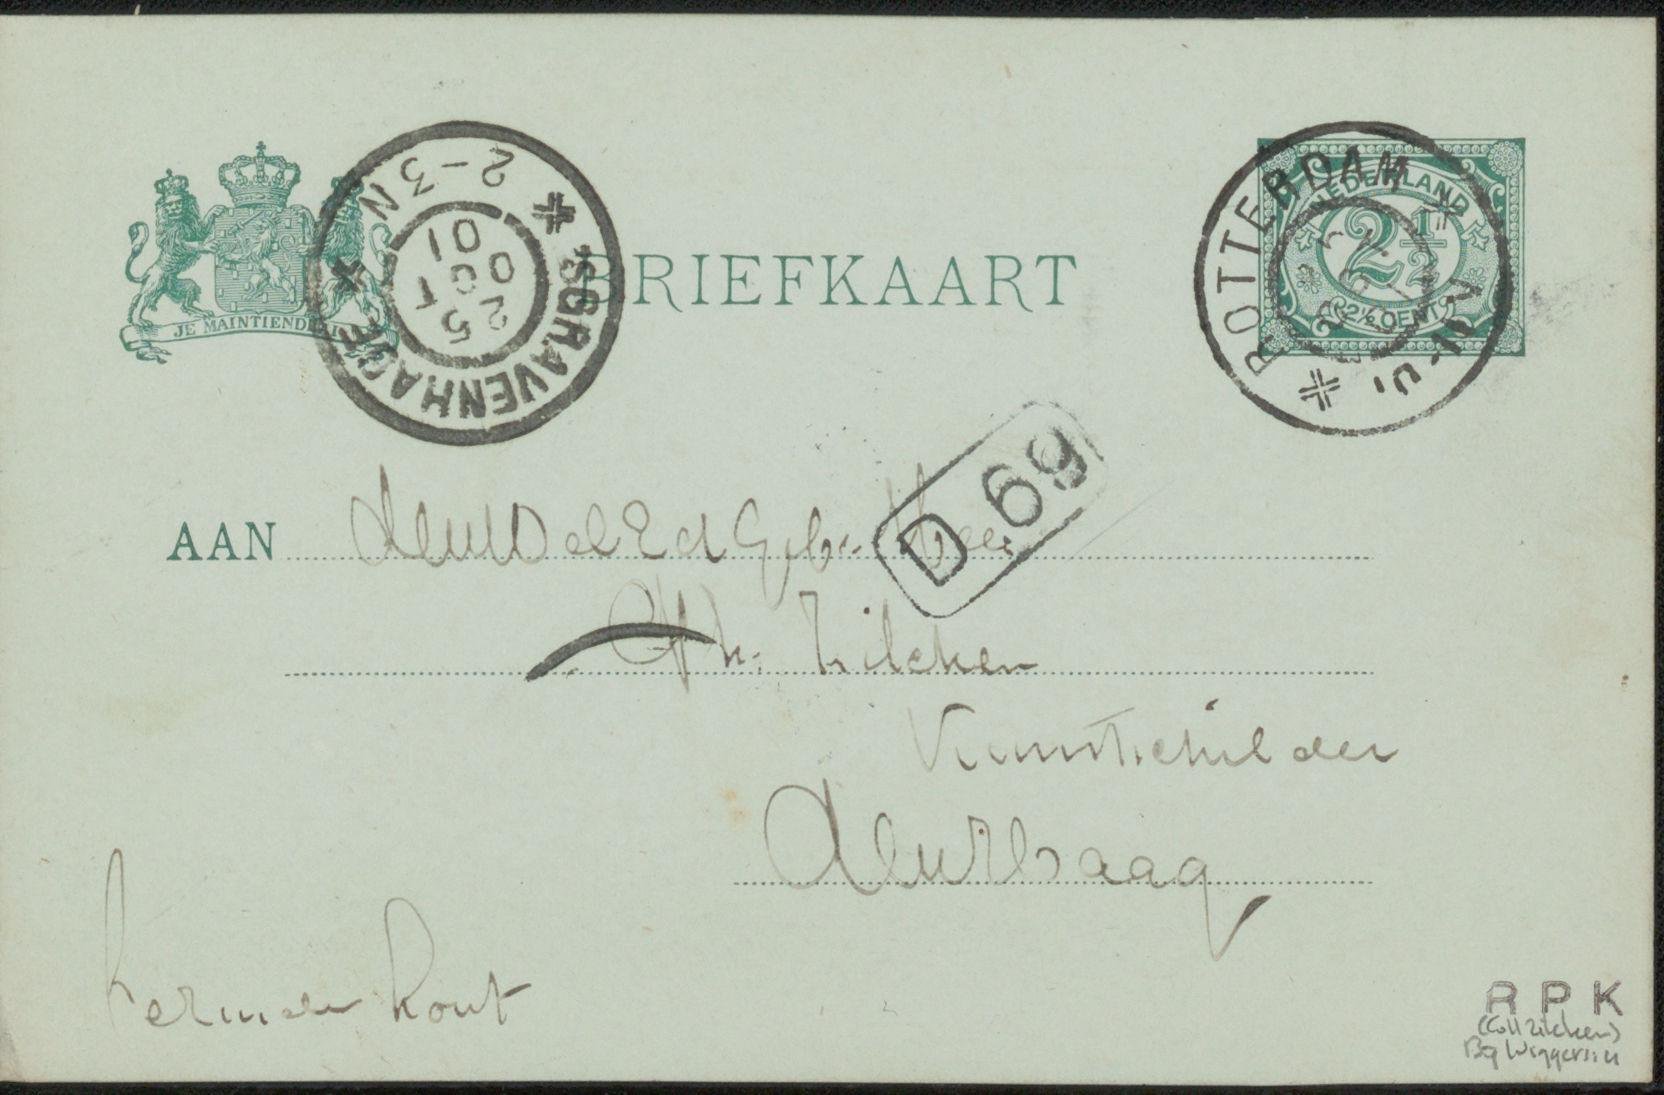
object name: postcard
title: Briefkaart aan Philip Zilcken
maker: derk wiggers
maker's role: draughtsman, painter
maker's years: 1866-1933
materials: cardboard, ink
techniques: pen, writing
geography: rotterdam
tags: martinus mouton, the hague, painter, draughtsman, philip zilcken, the graphic arts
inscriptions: collector's mark: ‘RPK’